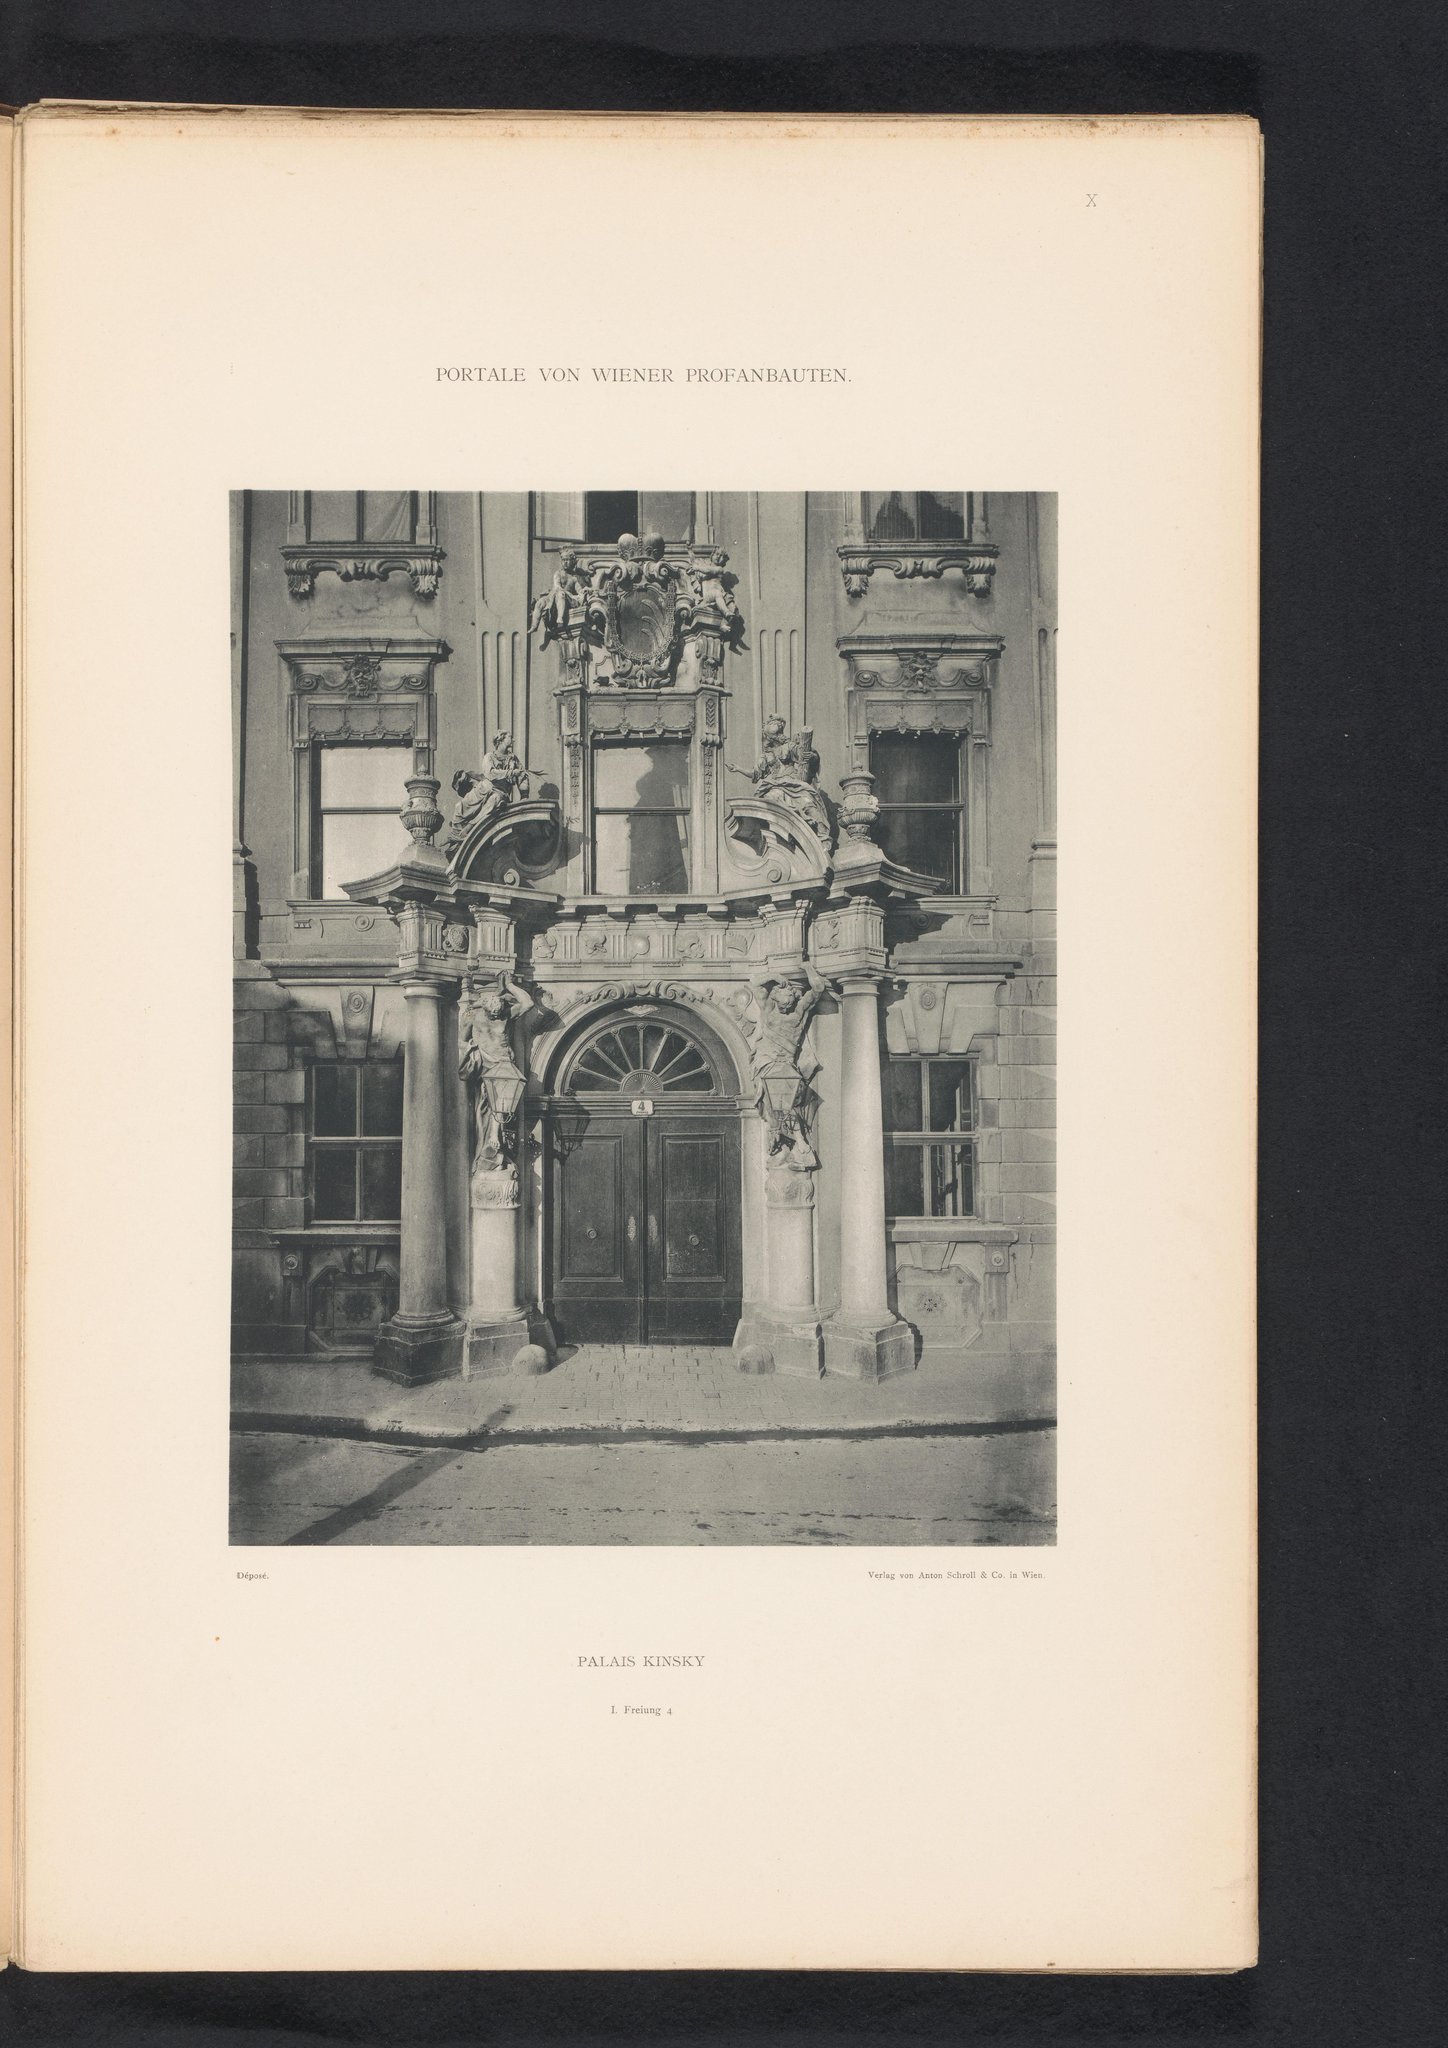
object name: page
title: Palais Kinsky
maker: Anonymous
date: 1884-1894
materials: paper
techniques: photograph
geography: vienna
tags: gate, entrance, façade (of house or building)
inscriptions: inscription: ‘I. Freiung 4’, number: ‘X’